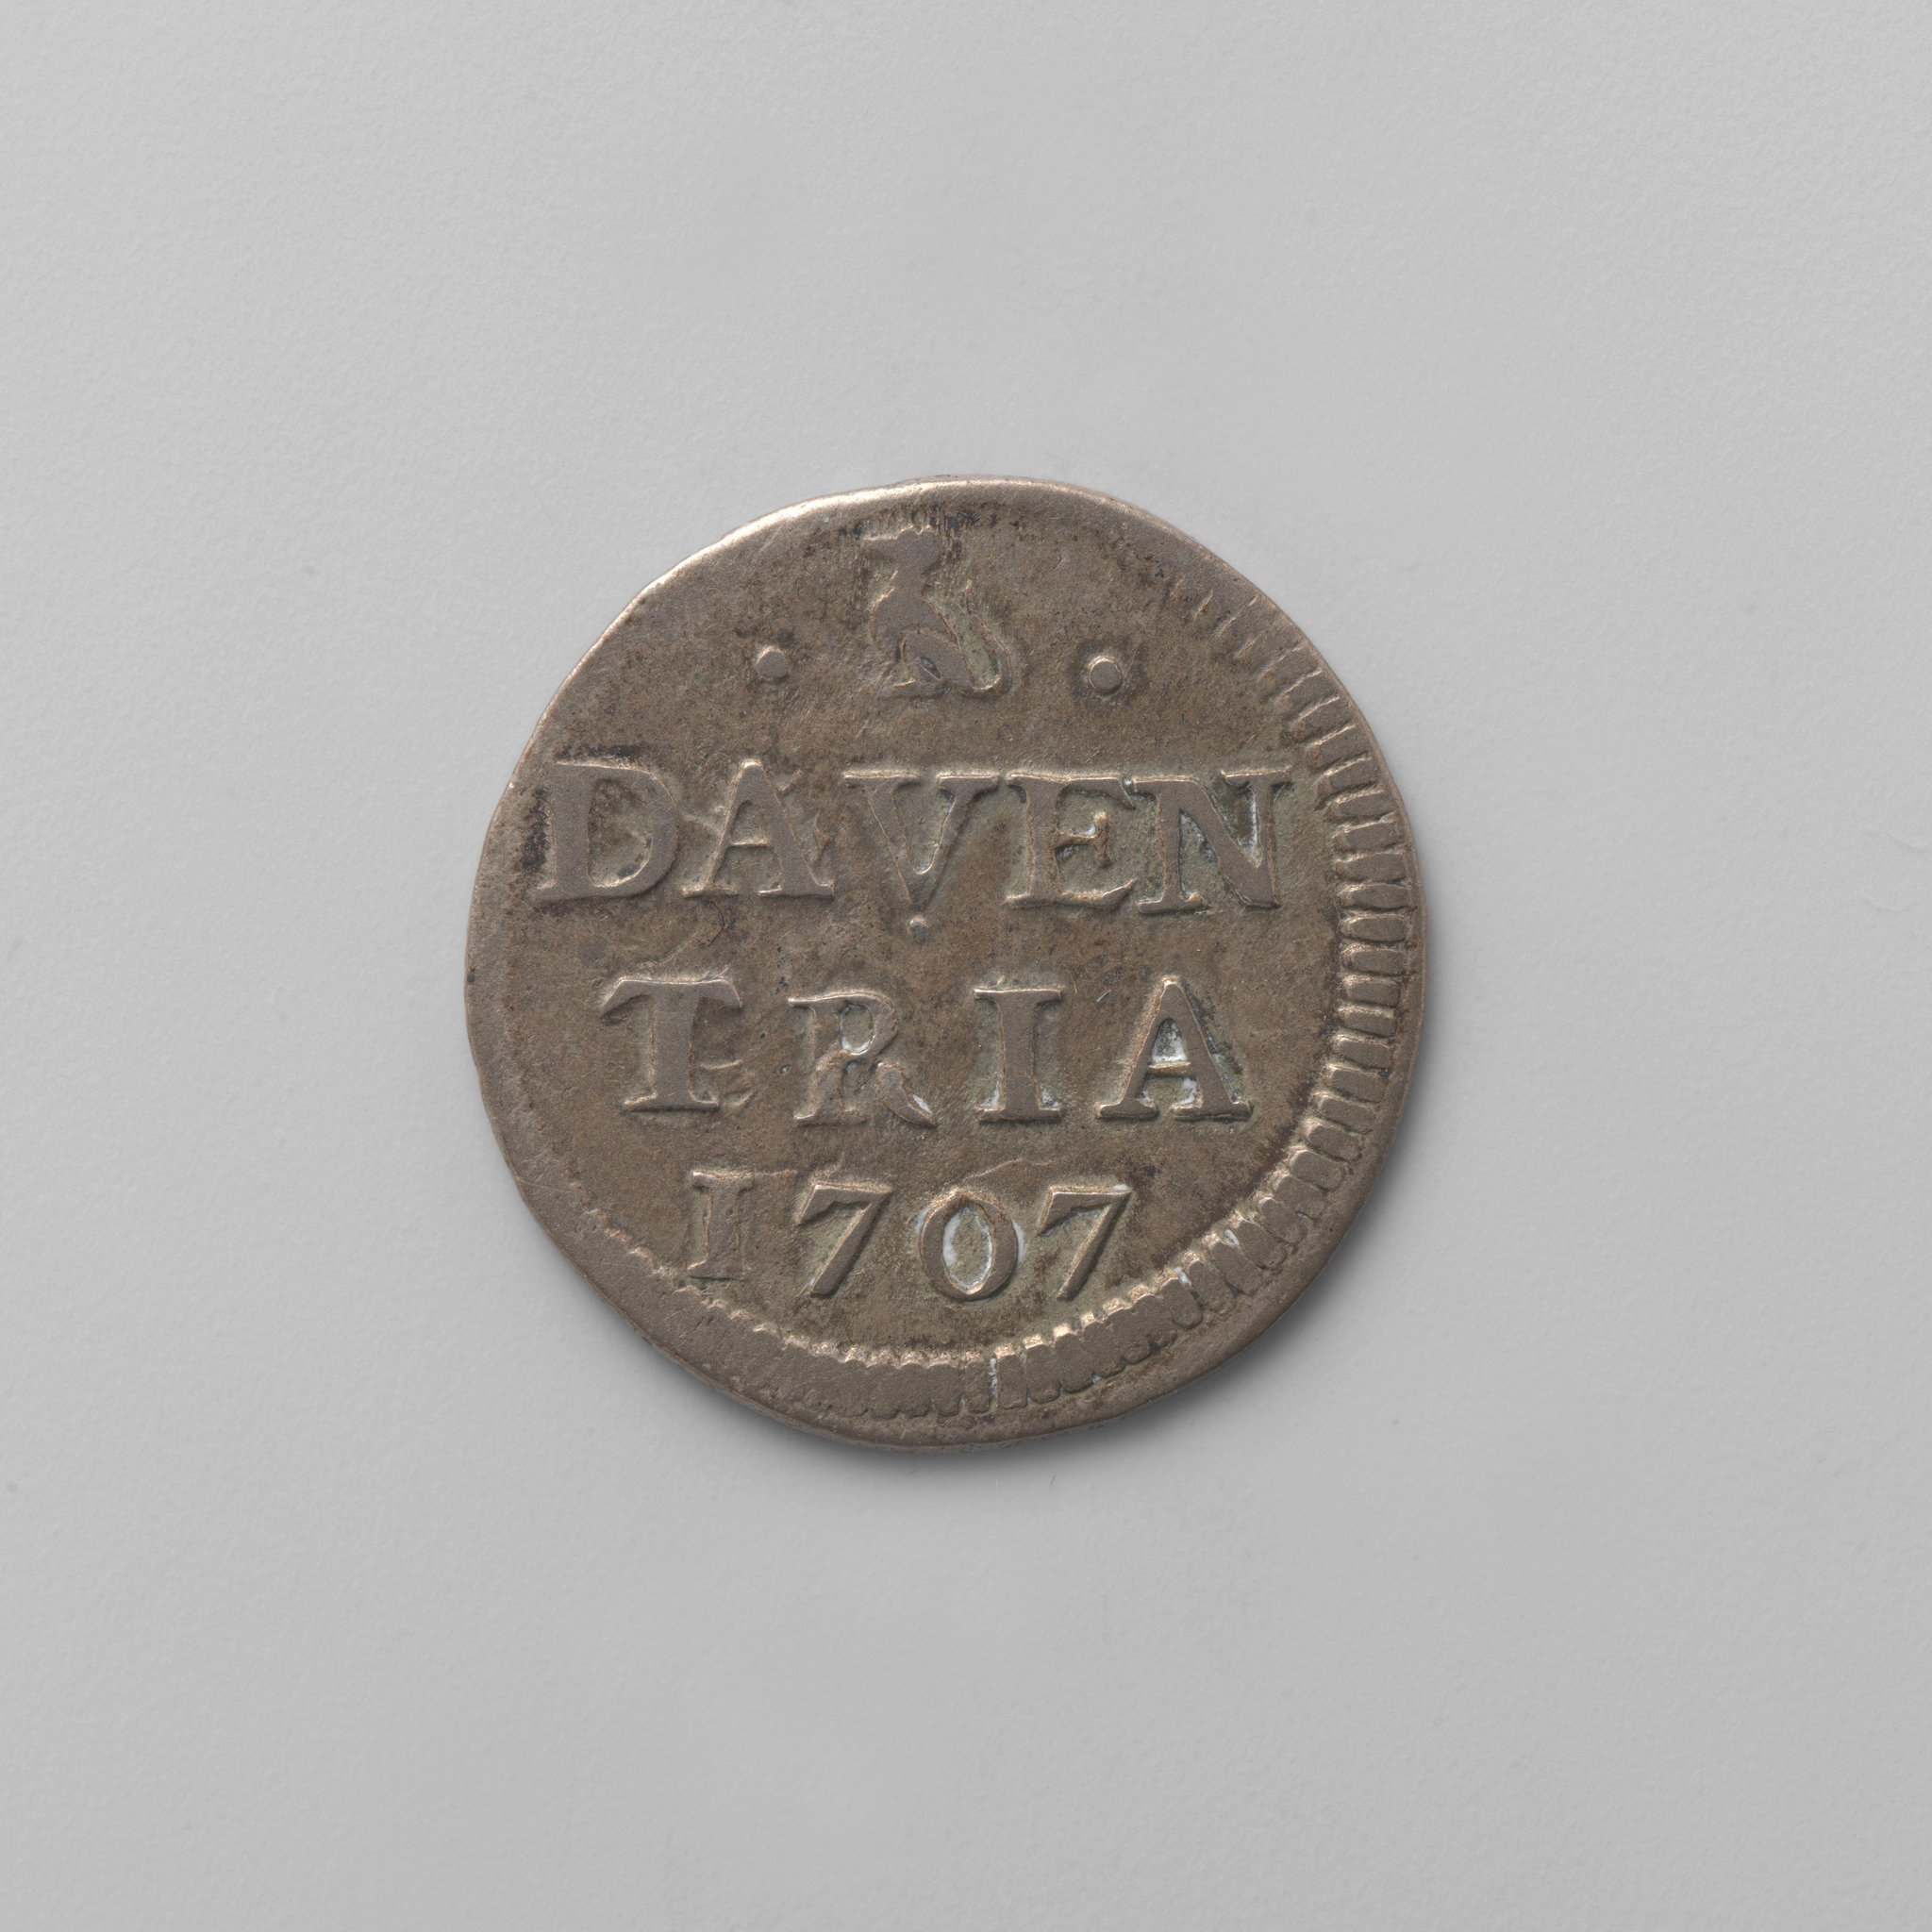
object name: coin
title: Deventer, dubbele stuiver, 1707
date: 1707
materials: silver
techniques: striking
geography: deventer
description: Zilveren munt. Voorzijde: tussen waarde-aanduiding 2 S generaliteitsleeuw. Keerzijde: tweeregelig opschrift. Daarboven muntmeesterteken en daaronder jaartal.